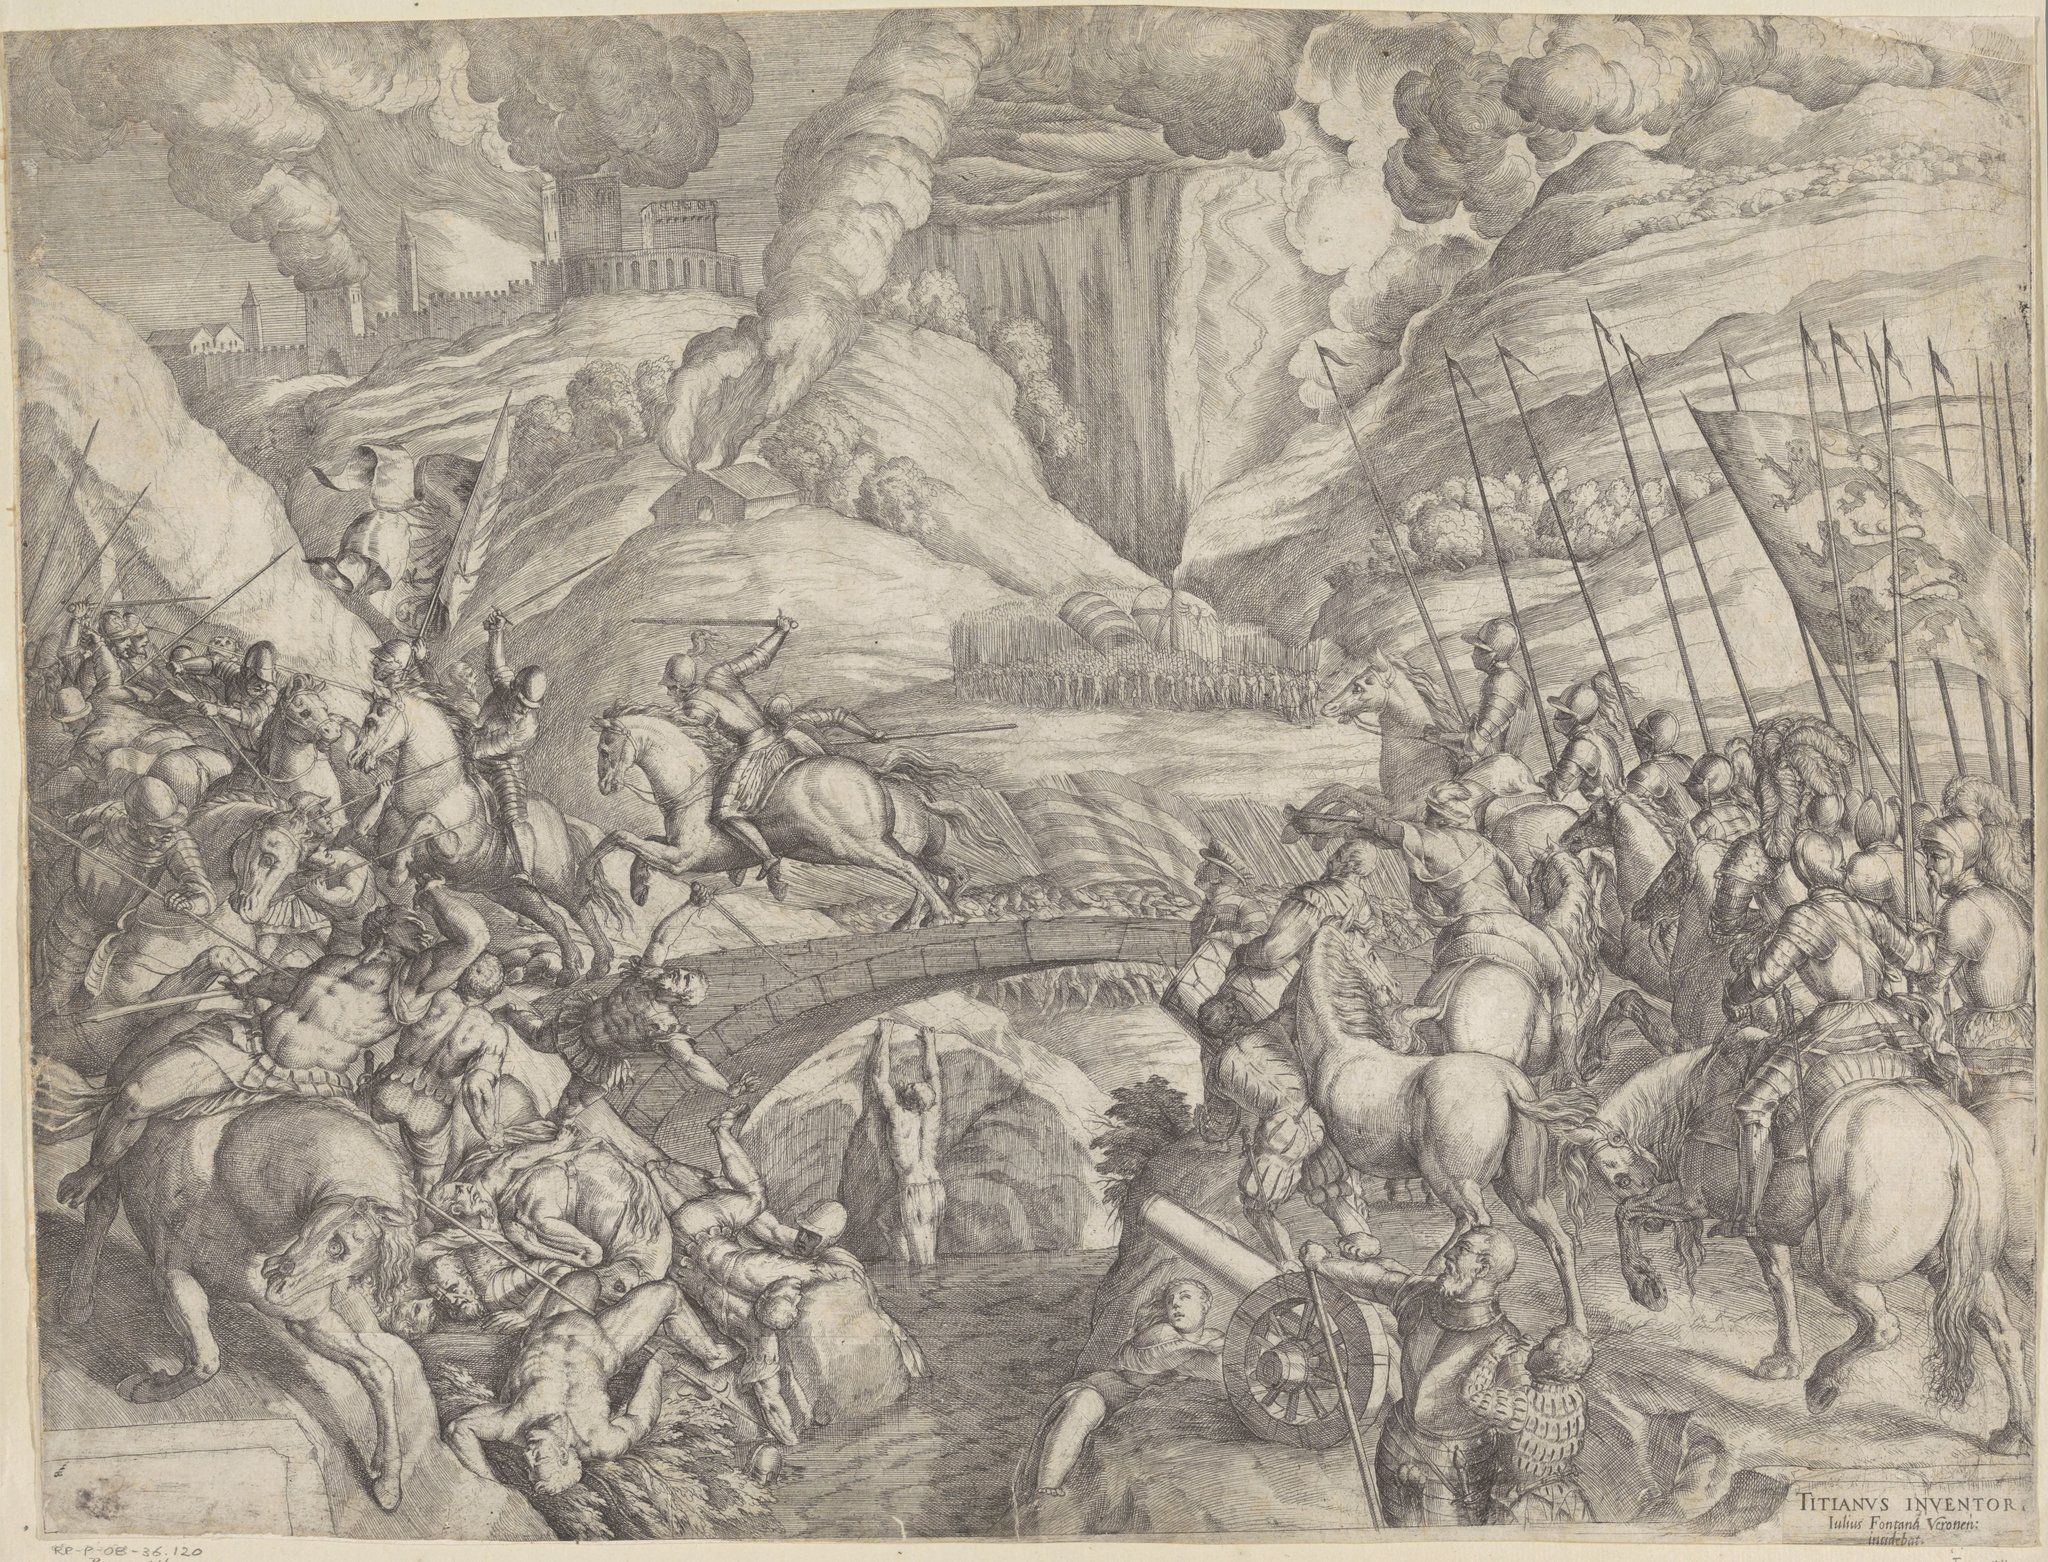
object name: print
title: De Slag bij Cadore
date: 1553-1582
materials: paper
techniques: etching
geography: verona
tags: battle, warfare; military affairs (+ cavalry, horsemen), the soldier; the soldier's life, firearms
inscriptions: collector's mark: Lugt 240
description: Twee legers strijden tegen elkaar in een rivierlandschap, met een brug over de rivier. Op de achtergrond een brandende stad. Voorheen is gedacht dat de Slag bij Cadore werd uitgebeeld. Nu denkt men dat het de slag bij Spoleto in 1155 is, waarbij het leger van Keizer Frederick Barbarossa tegen de inwoners van Spoleto vocht, omdat deze paus Alexander III steunden.